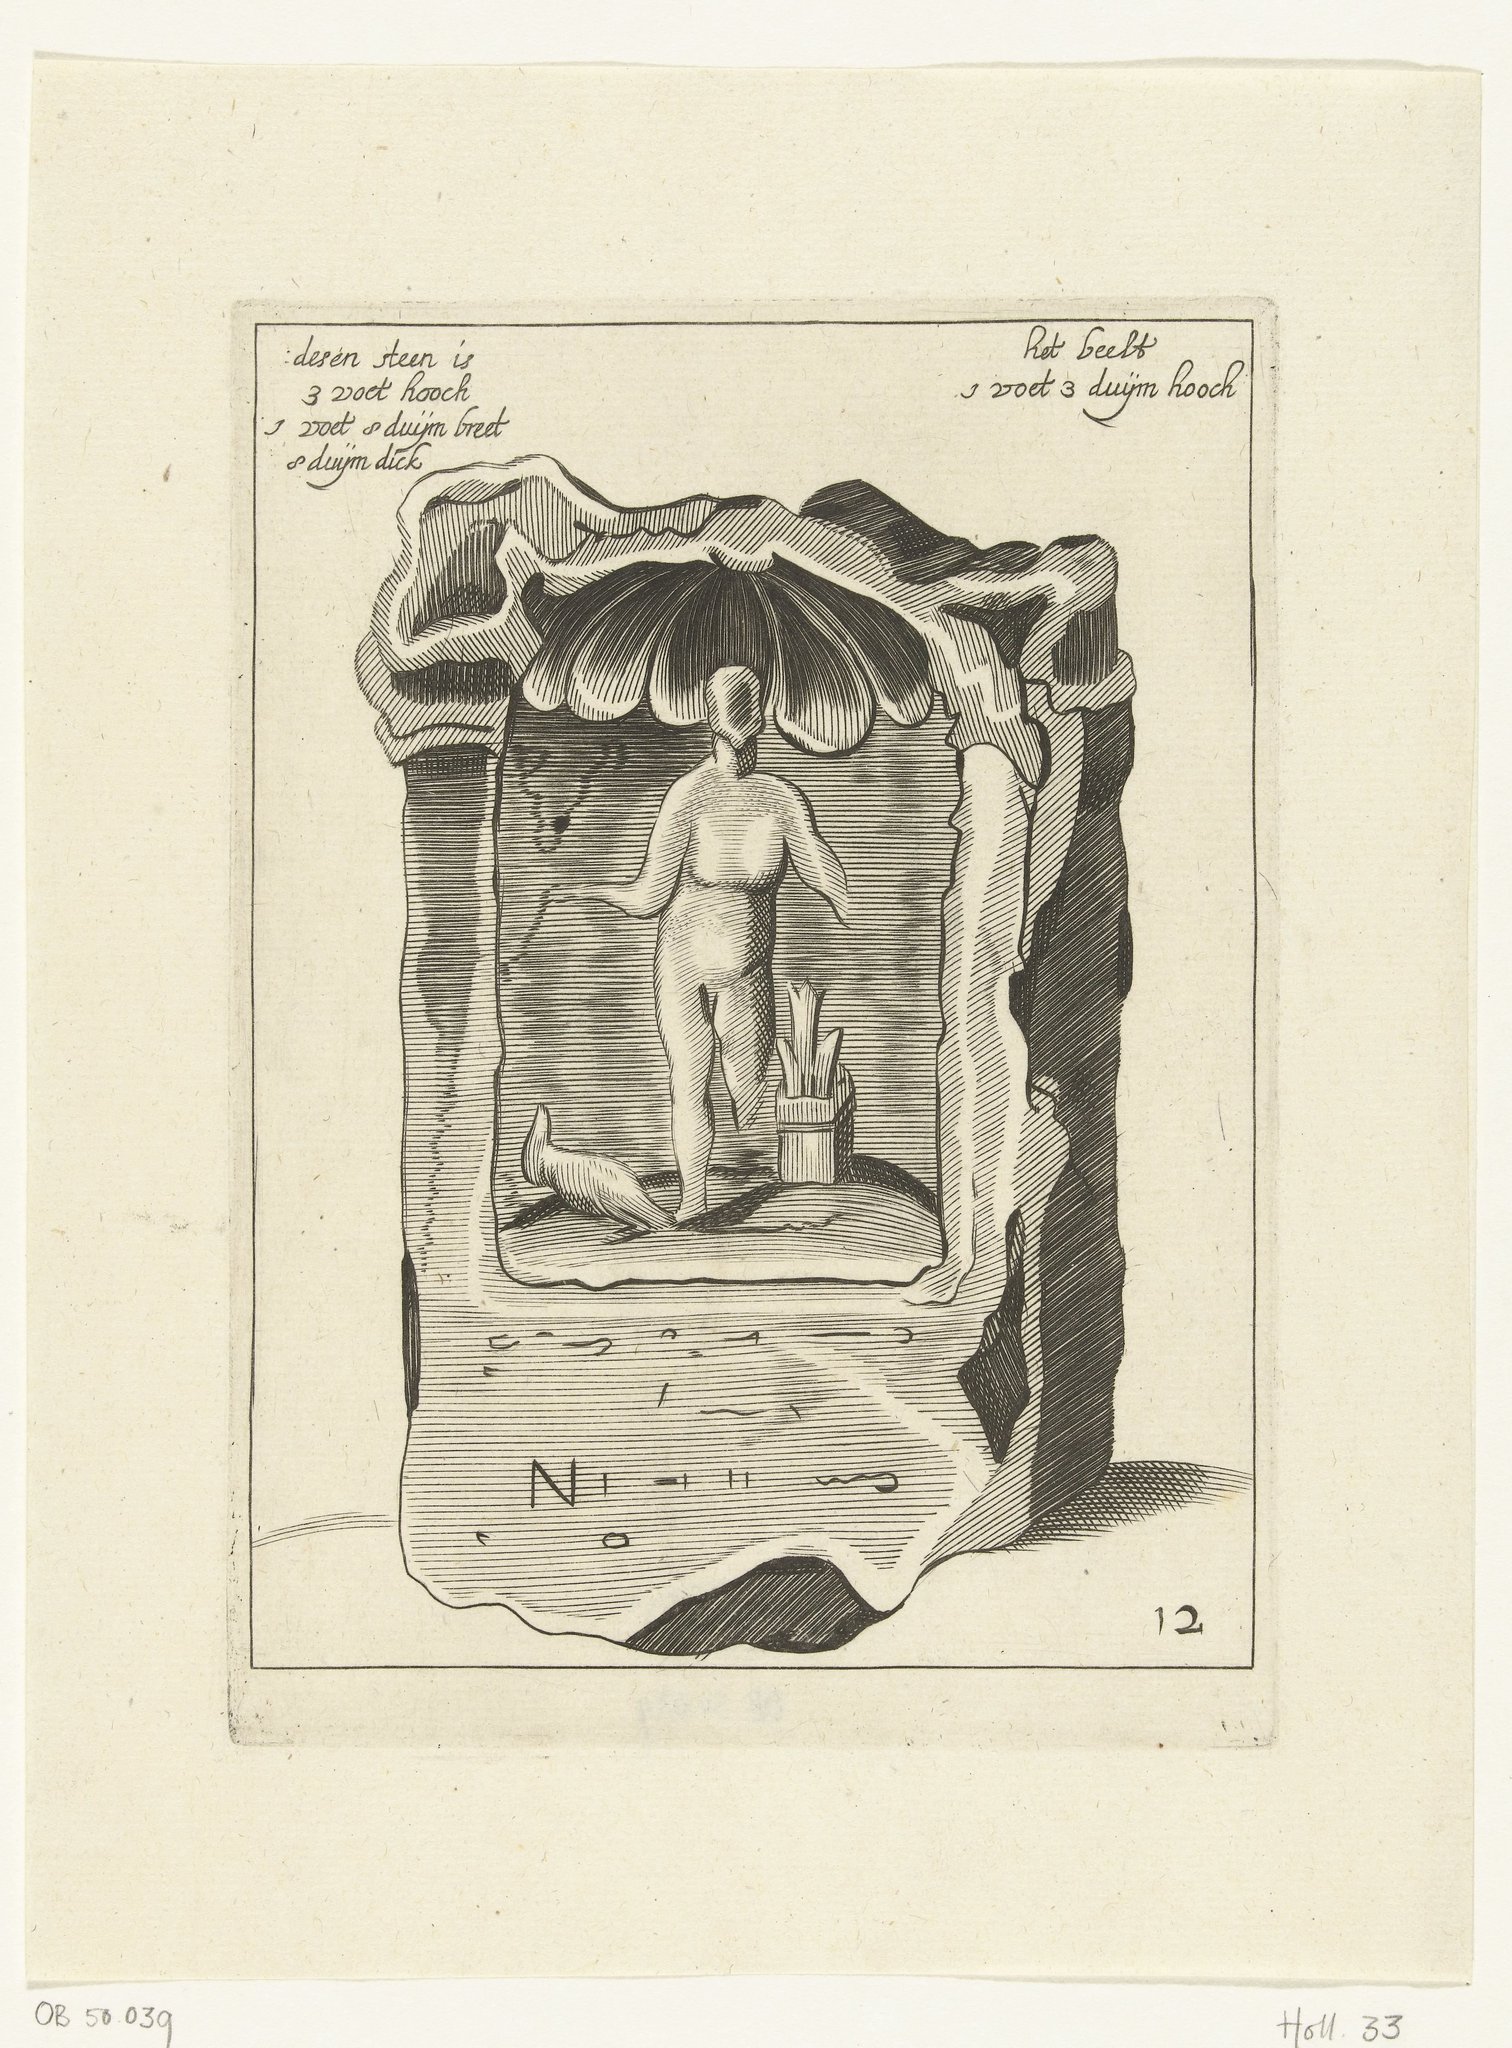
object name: historical object representation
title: Sterk verweerd Romeins altaar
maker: hendrick danckerts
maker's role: print maker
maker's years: 1625-1679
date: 1647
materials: paper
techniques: engraving, etching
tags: other foreign deities included in the classical pantheon (with name)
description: Sterk verweerd Romeins altaar, misschien van de Romeinse godin Nehalennia.